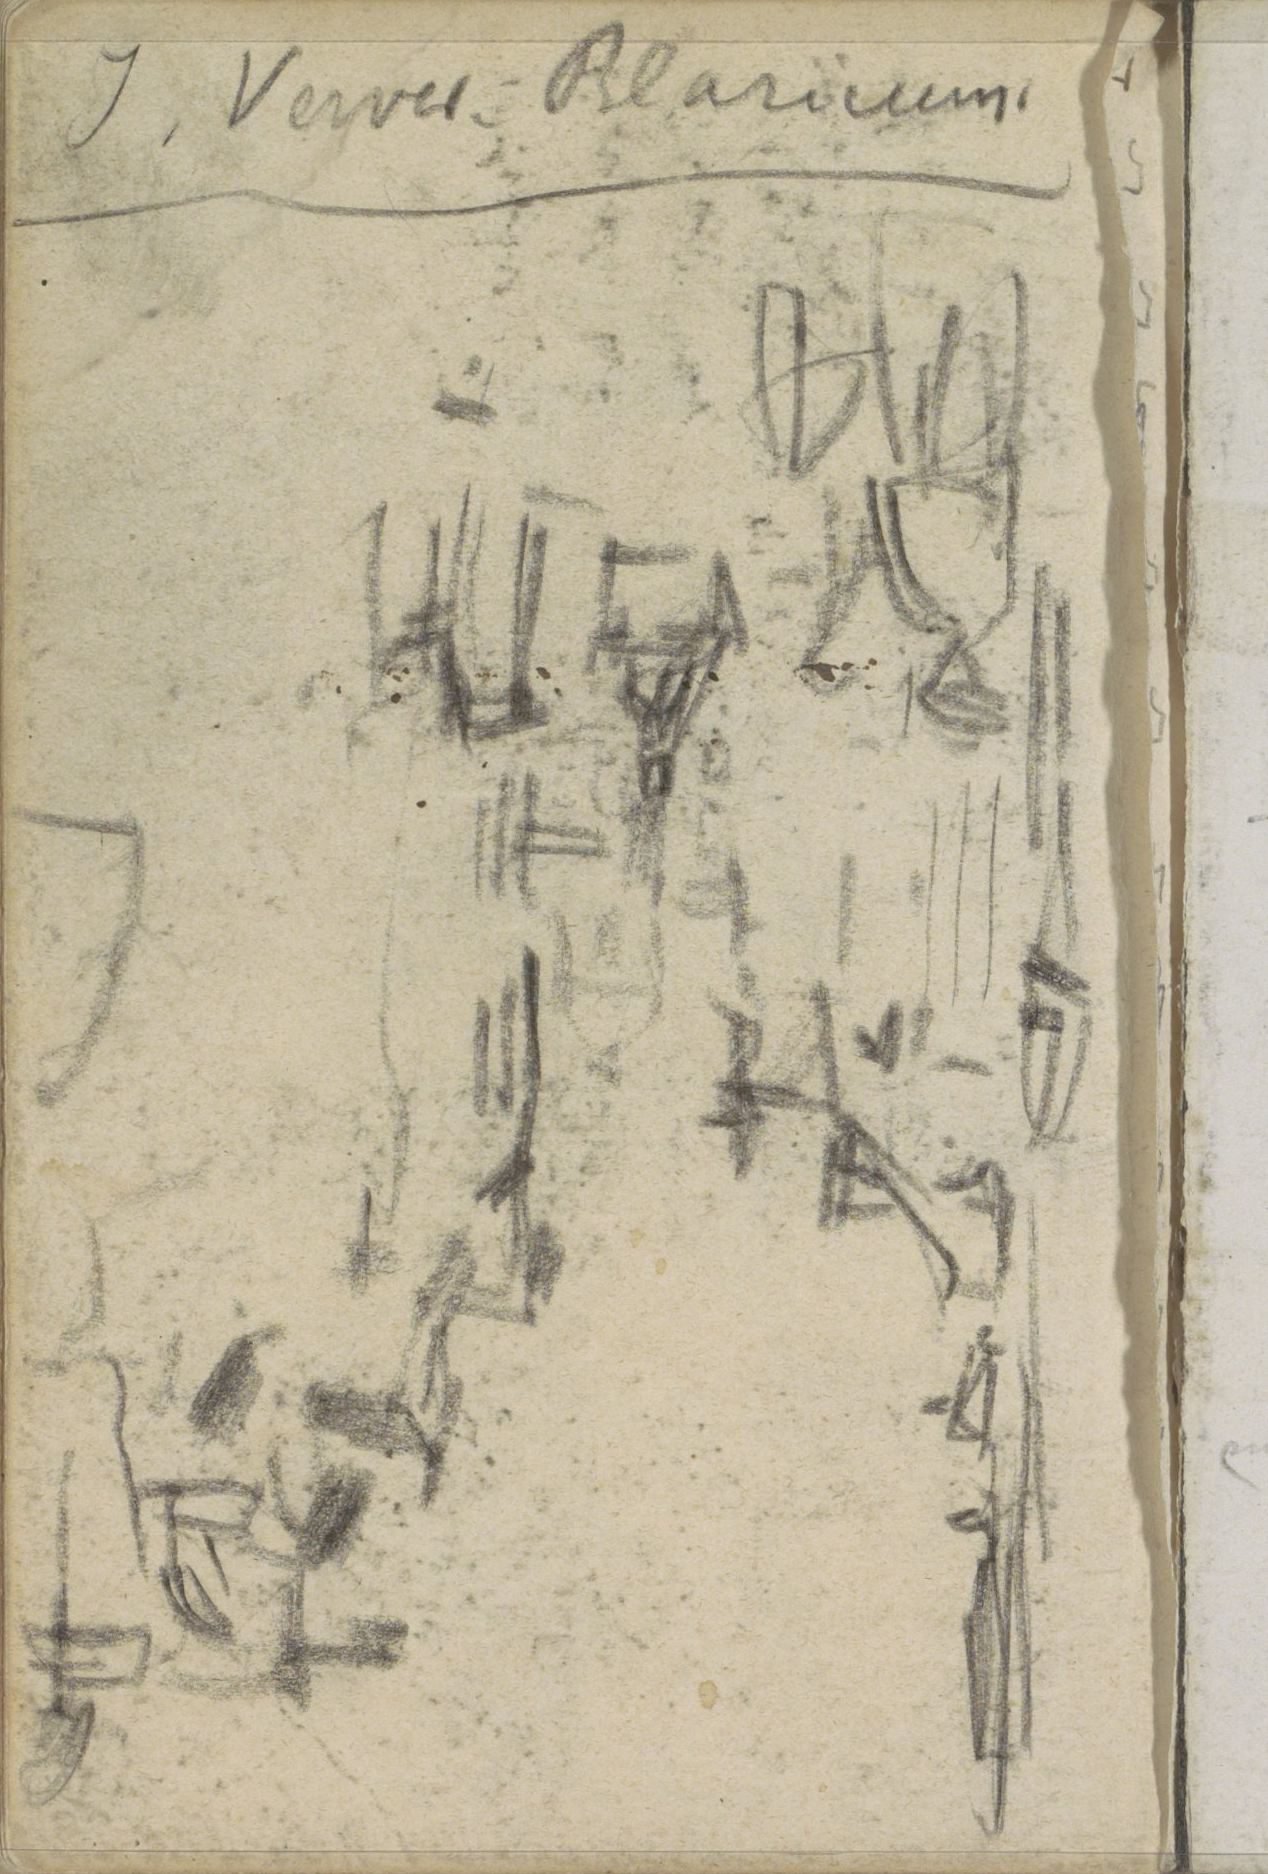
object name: sketchbook leaf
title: Gezicht op de Oude Hoogstraat te Amsterdam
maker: george hendrik breitner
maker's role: draughtsman, painter, print maker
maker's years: 1857-1923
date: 1900-1923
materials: chalk, paper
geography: amsterdam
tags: urban housing, street (+ city(-scape) with figures, staffage), royal palace of amsterdam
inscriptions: annotation: ‘J. Verver Blaricum.’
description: In het Amsterdamse stadsarchief bevindt zich een foto van Breitner met een bijna identieke voorstelling.